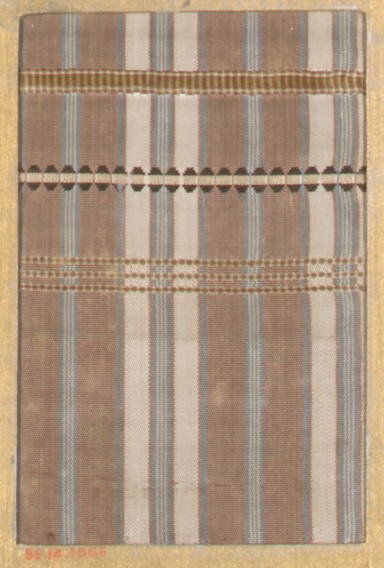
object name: piece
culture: japanese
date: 1701-1900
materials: silk